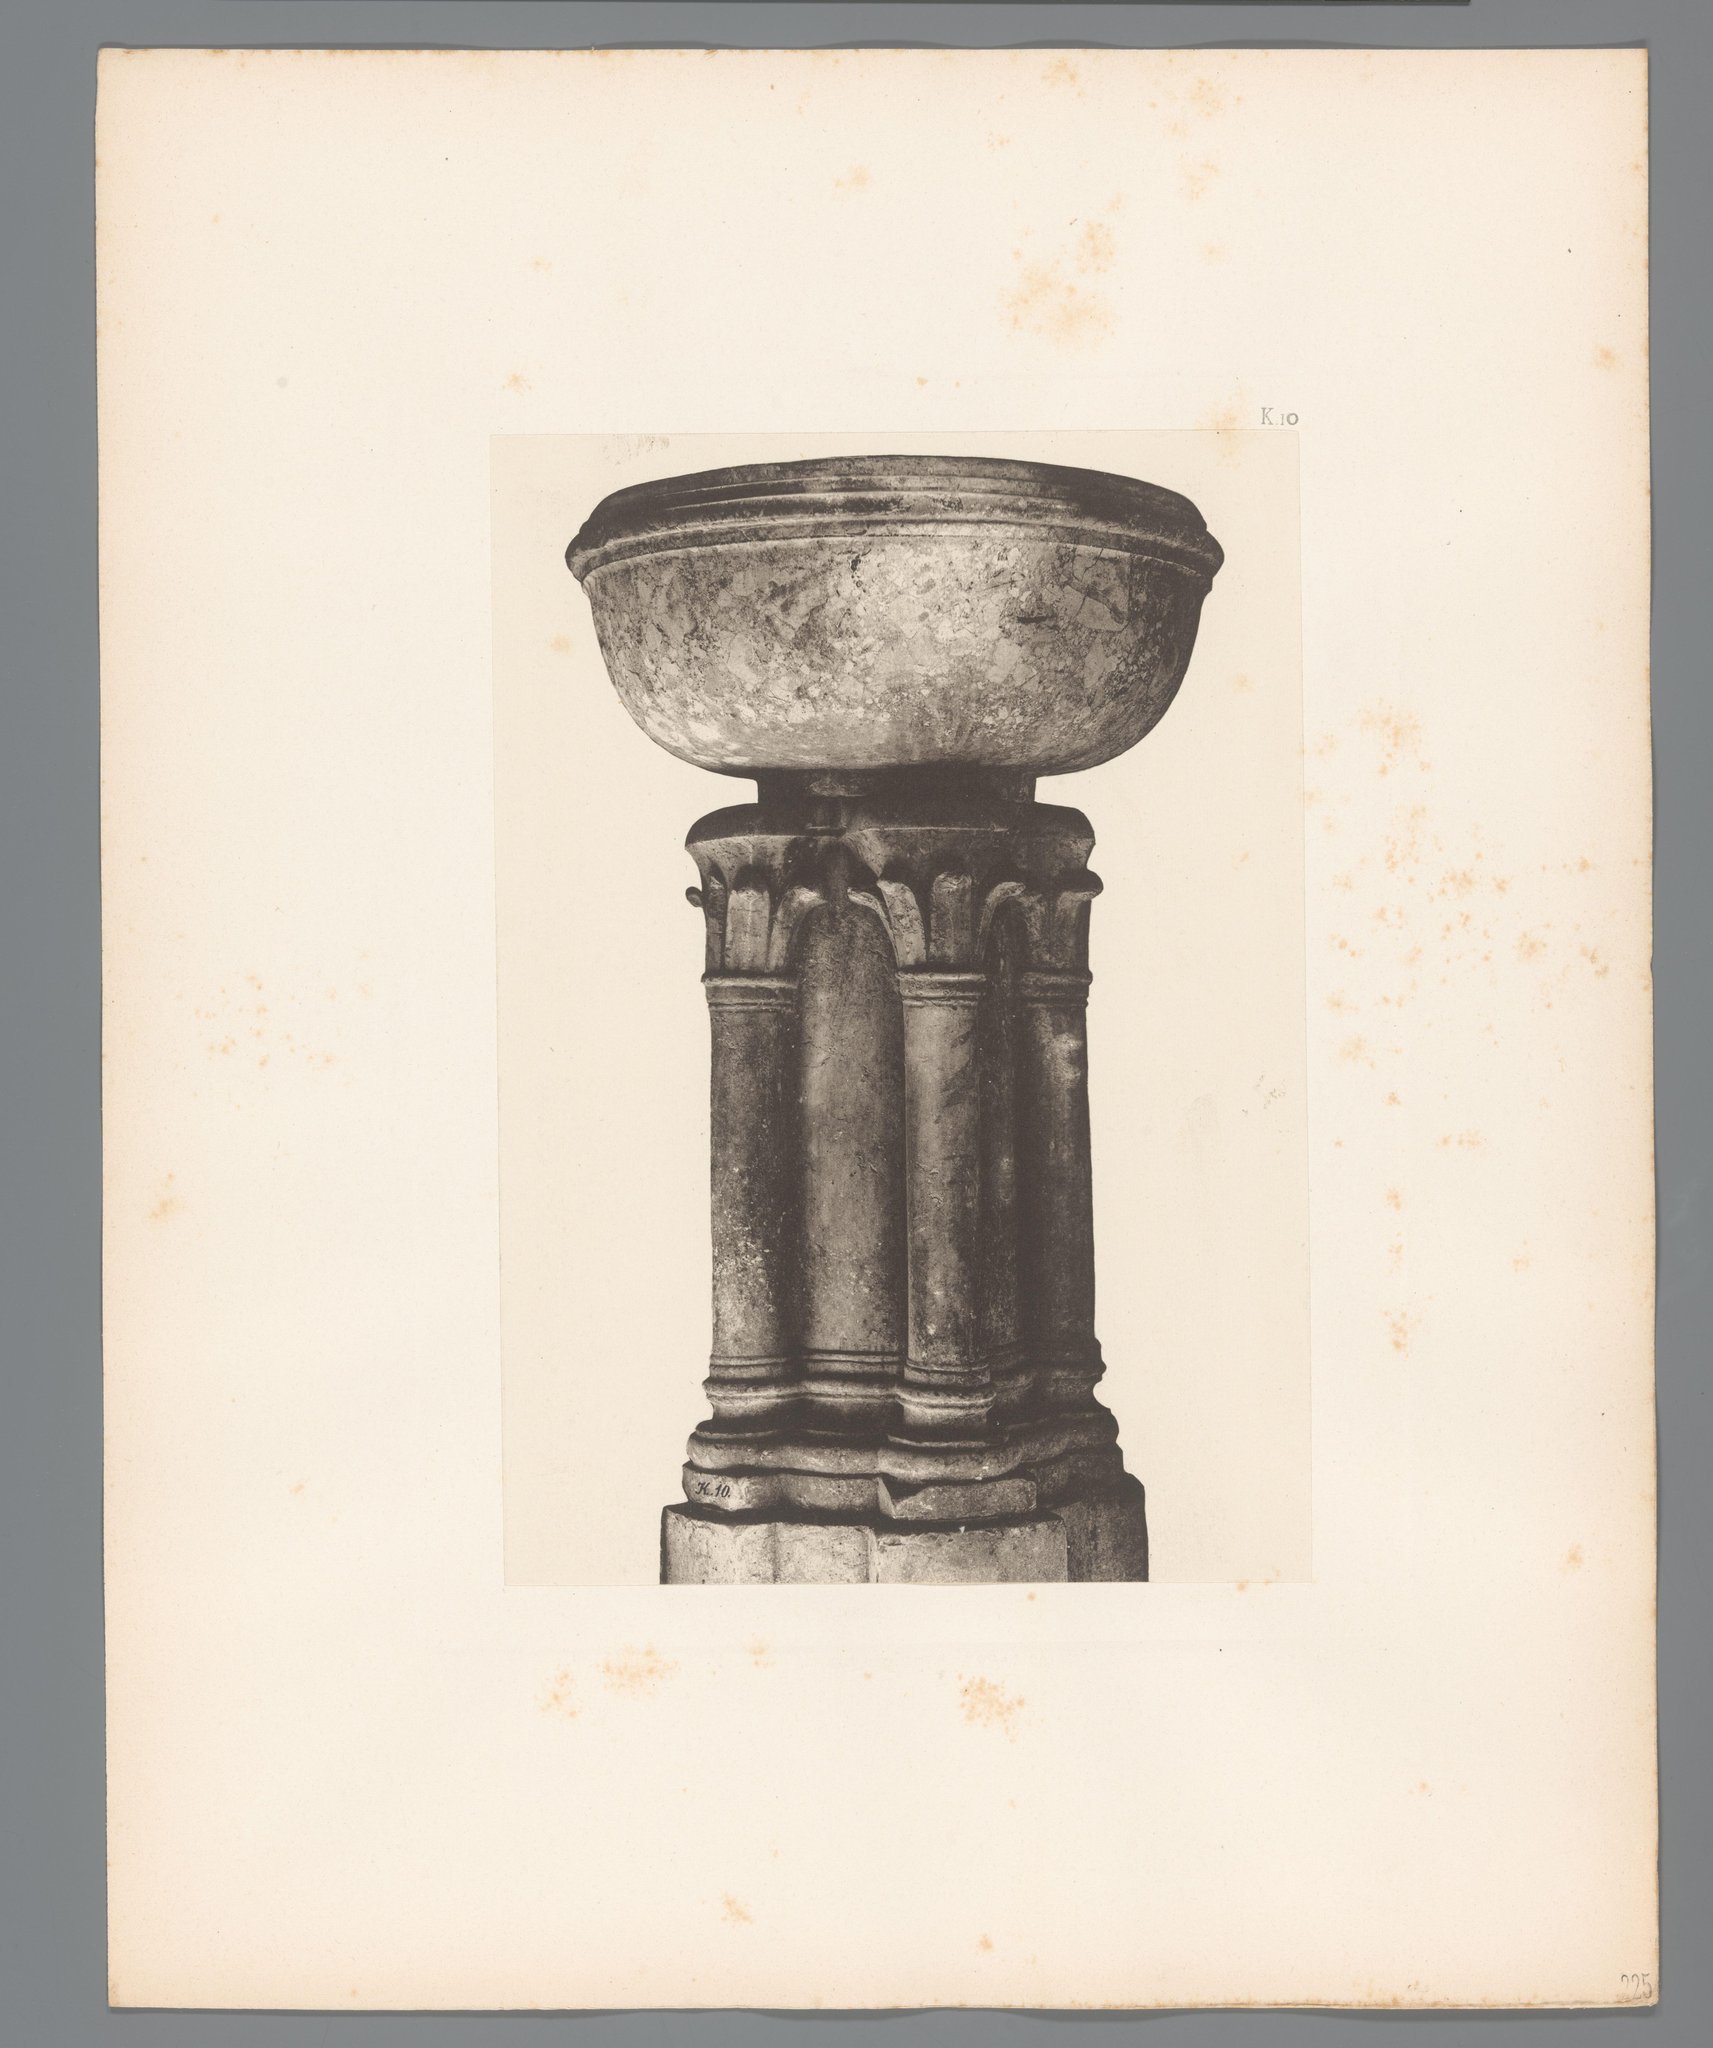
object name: photomechanical print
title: Deel van een zuil van de San Marco in Venetië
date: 1880-1885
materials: paper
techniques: photograph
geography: venice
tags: column, pillar ~ architecture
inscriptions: number: ‘K.10.’, number: ‘225’, number: ‘K.10’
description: Deze prent maakt deel uit van een omslag met 79 prenten op 53 bladen en 2 tekstbladen.